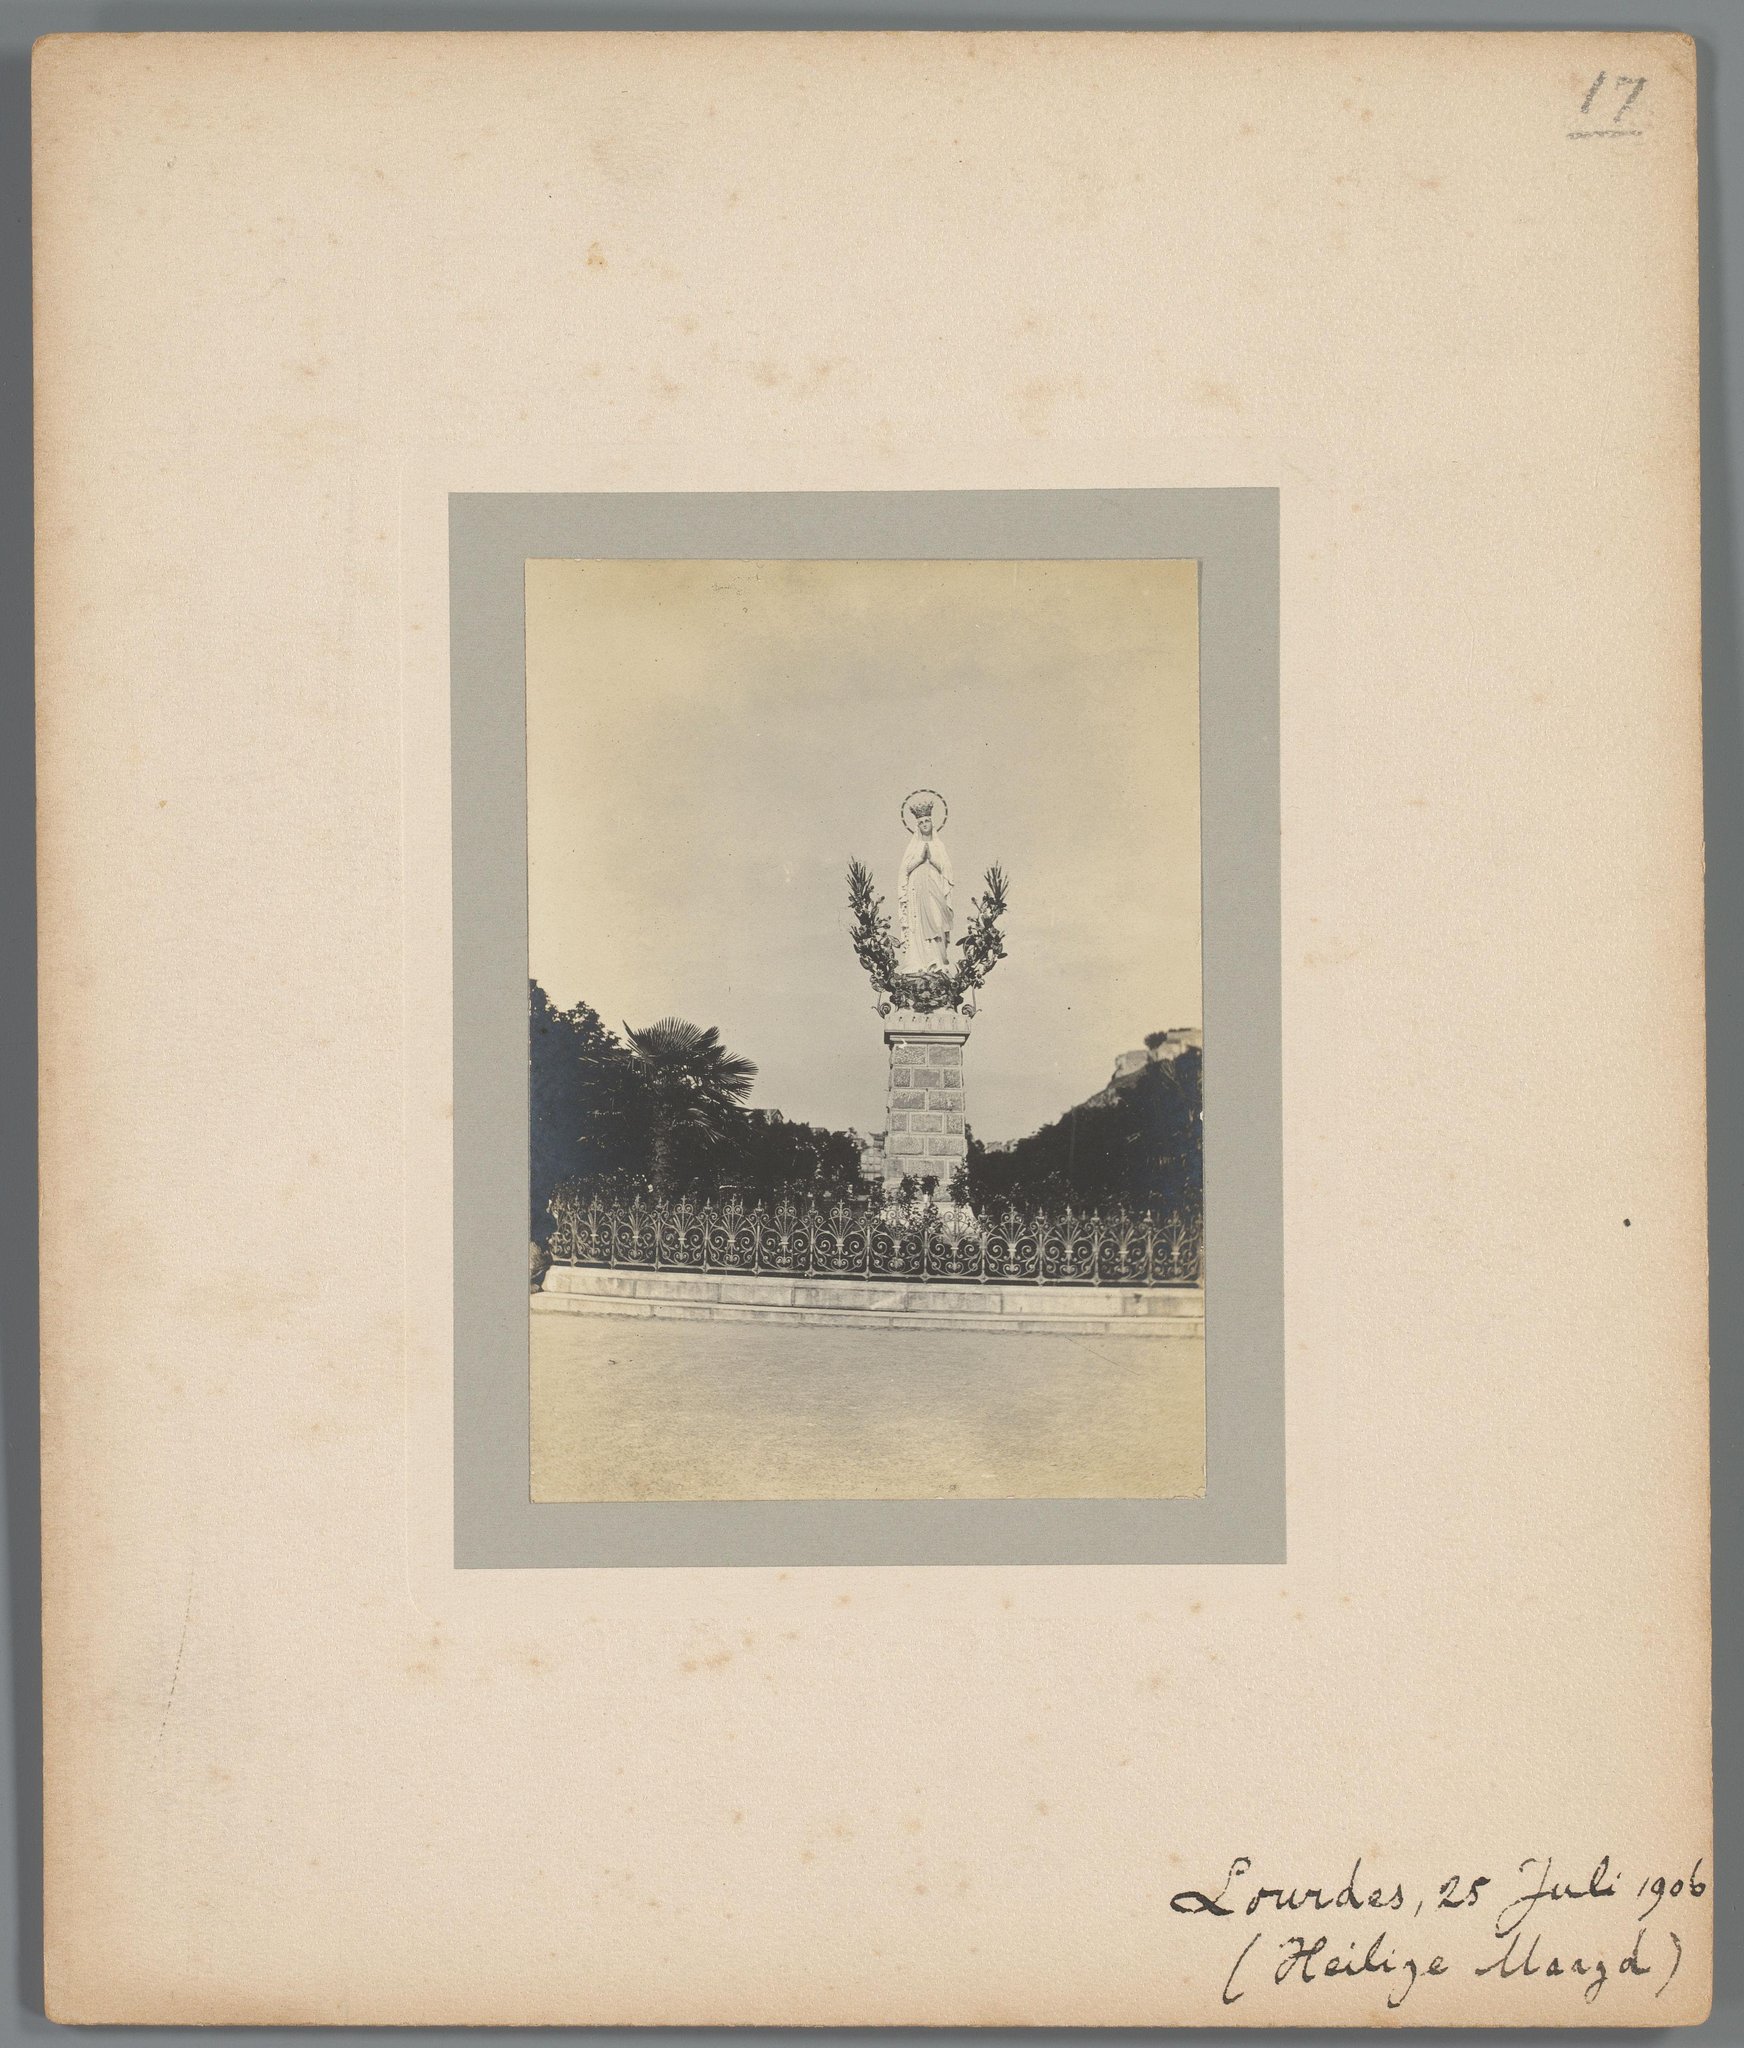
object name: photograph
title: Beeld van de Heilige Maagd Maria in Lourdes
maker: françois buys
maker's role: advocaat, amateurfotograaf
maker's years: 1871-1934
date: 1906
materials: paper, cardboard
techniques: gelatin silver print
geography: lourdes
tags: piece of sculpture, reproduction of a piece of sculpture, mary devotion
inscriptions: number: ‘17’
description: Deze foto maakt deel uit van een groep van 49 foto's.